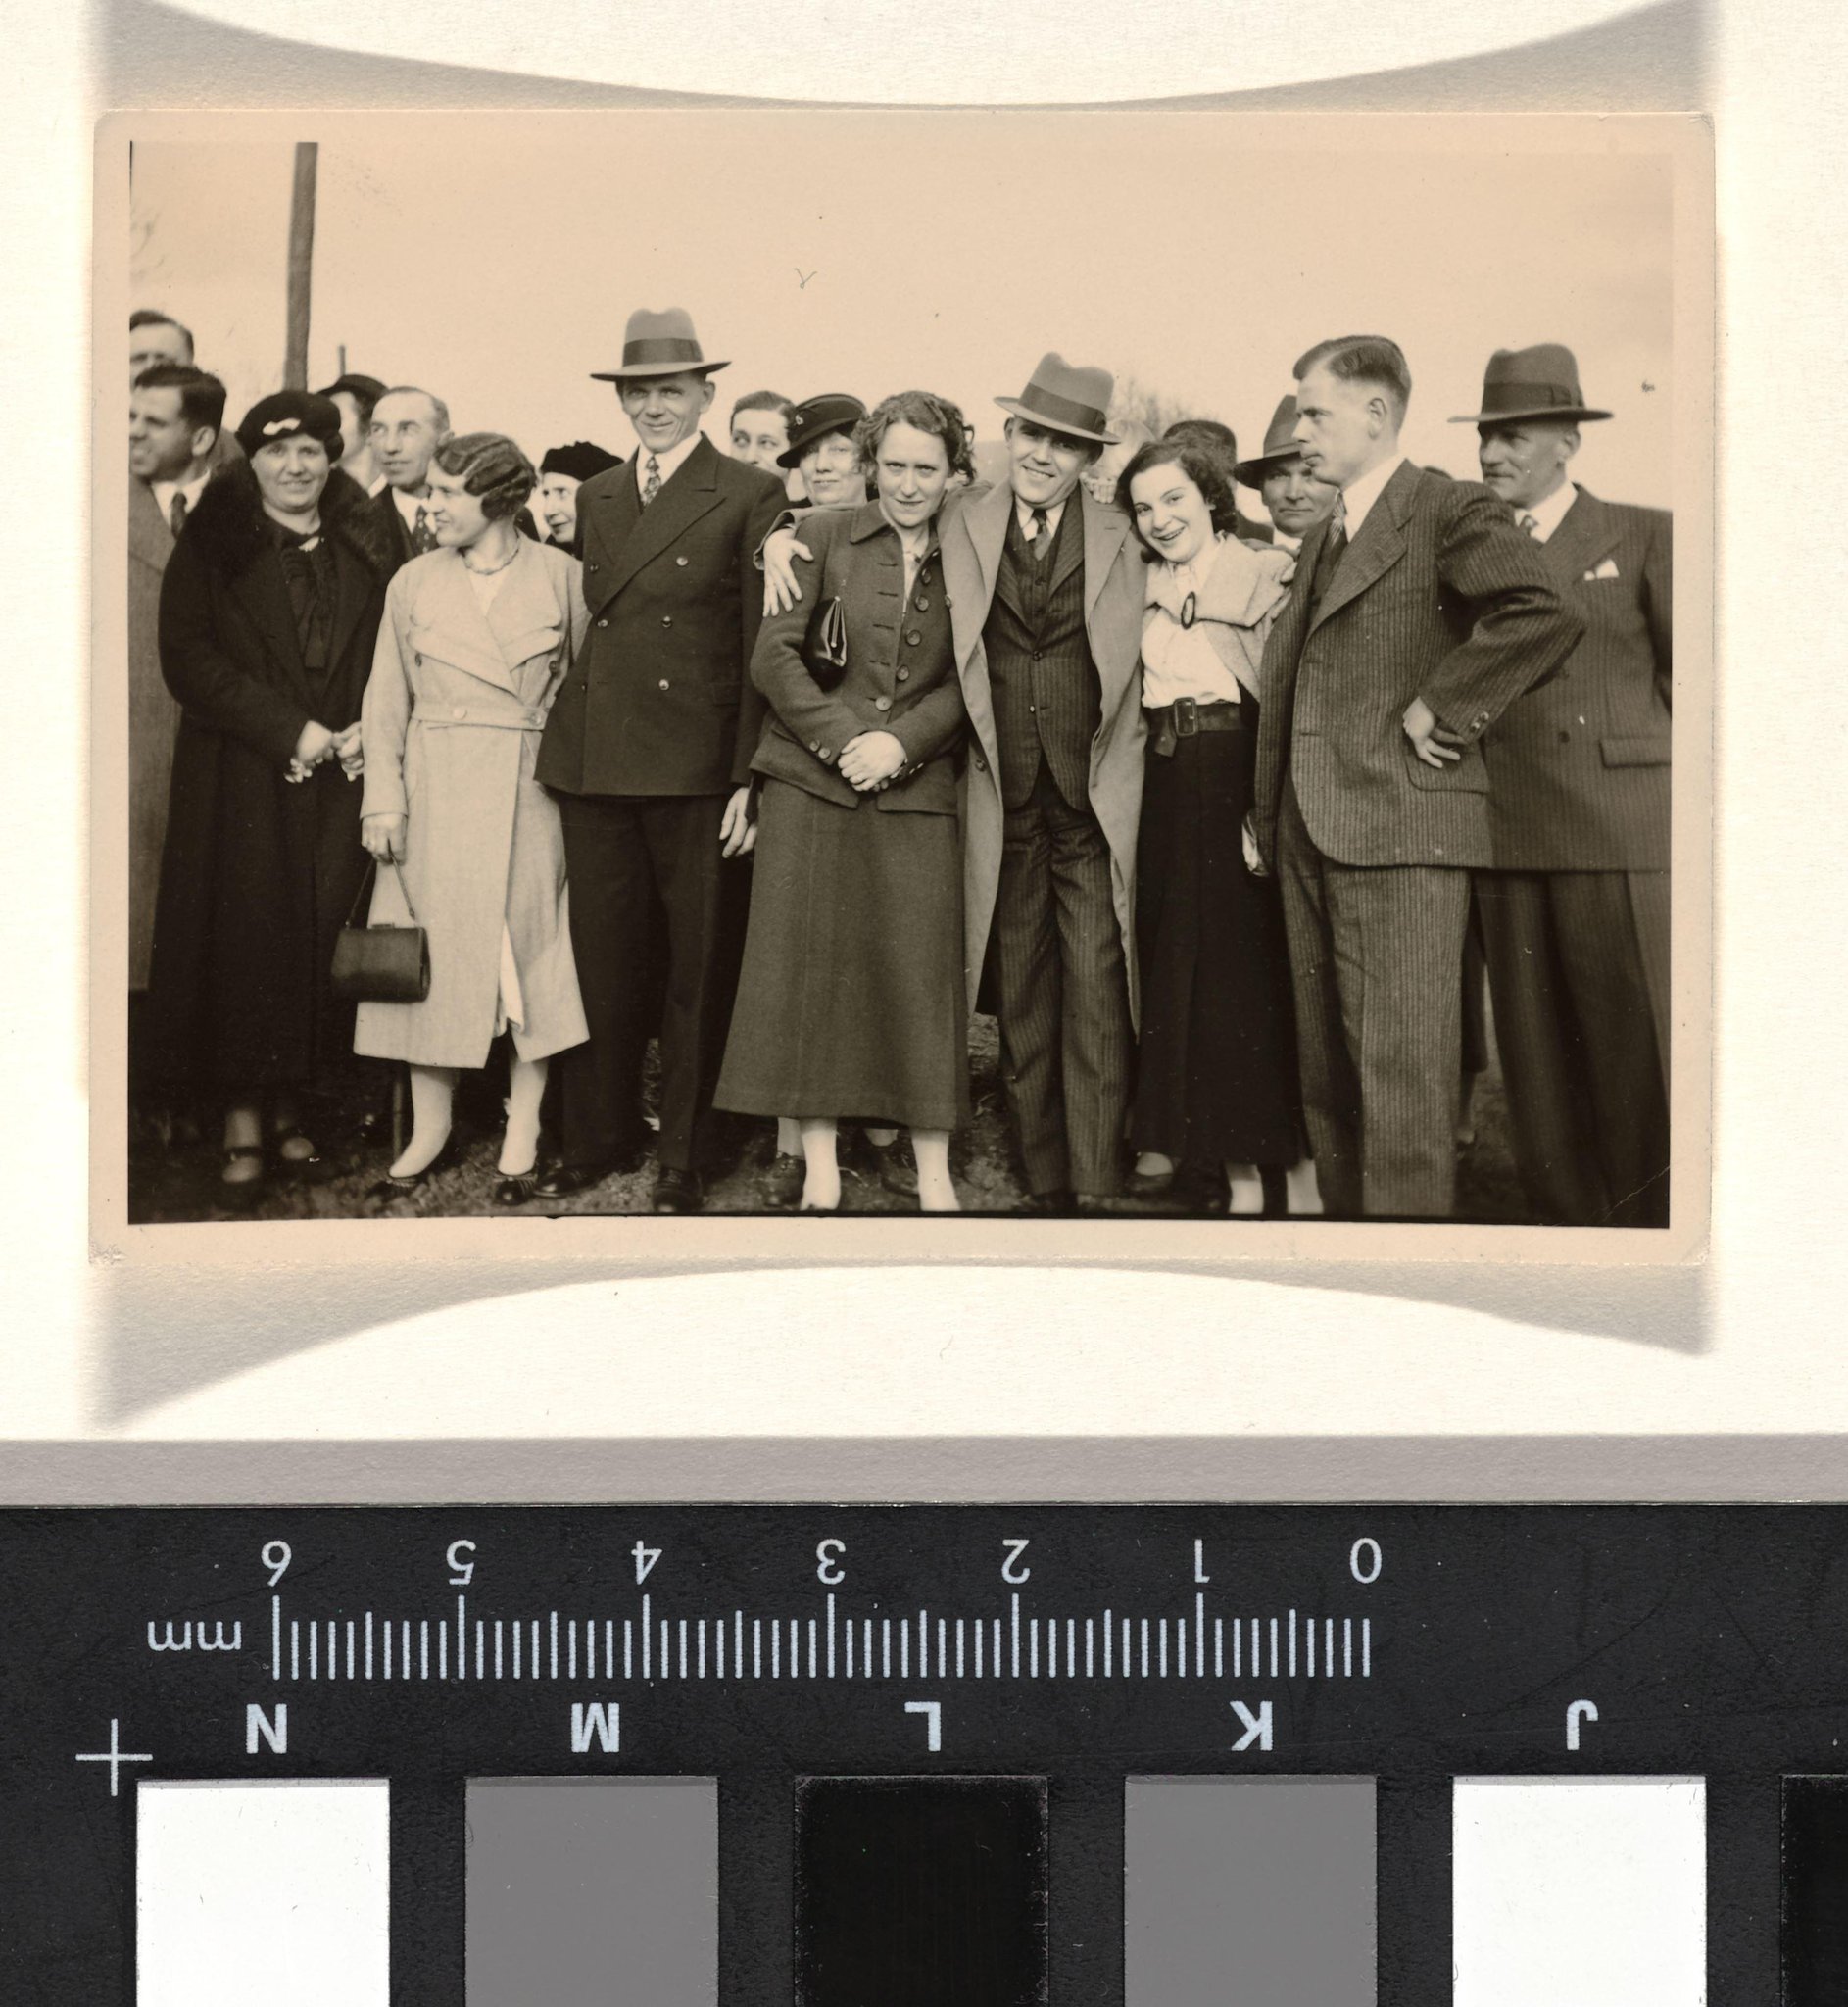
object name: photograph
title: Groep van onbekende mannen en vrouwen in een rij, waaronder drie mannen met gleufhoed en een man met gleufhoed met zijn arm om een vrouw heen geslagen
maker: Anonymous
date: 1930-1965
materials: photographic support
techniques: gelatin silver print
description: Groep van onbekende mannen en vrouwen in een rij, waaronder drie mannen met gleufhoed en een man met gleufhoed met zijn arm om een vrouw heen geslagen.